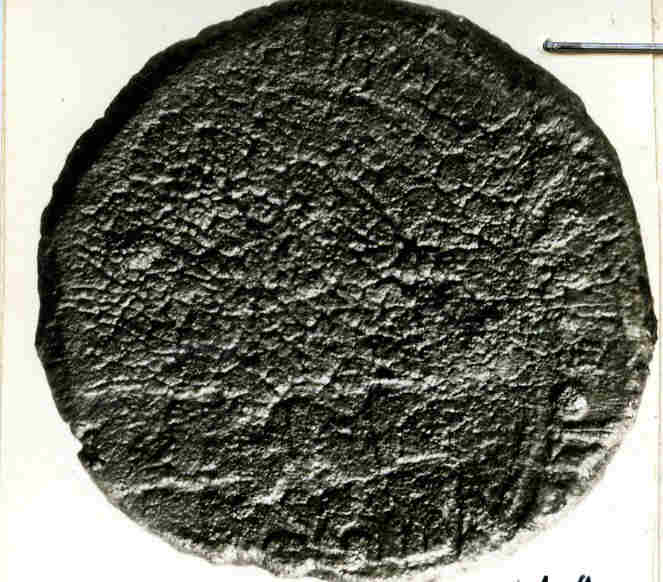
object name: coin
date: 1067-1100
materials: copper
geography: iran